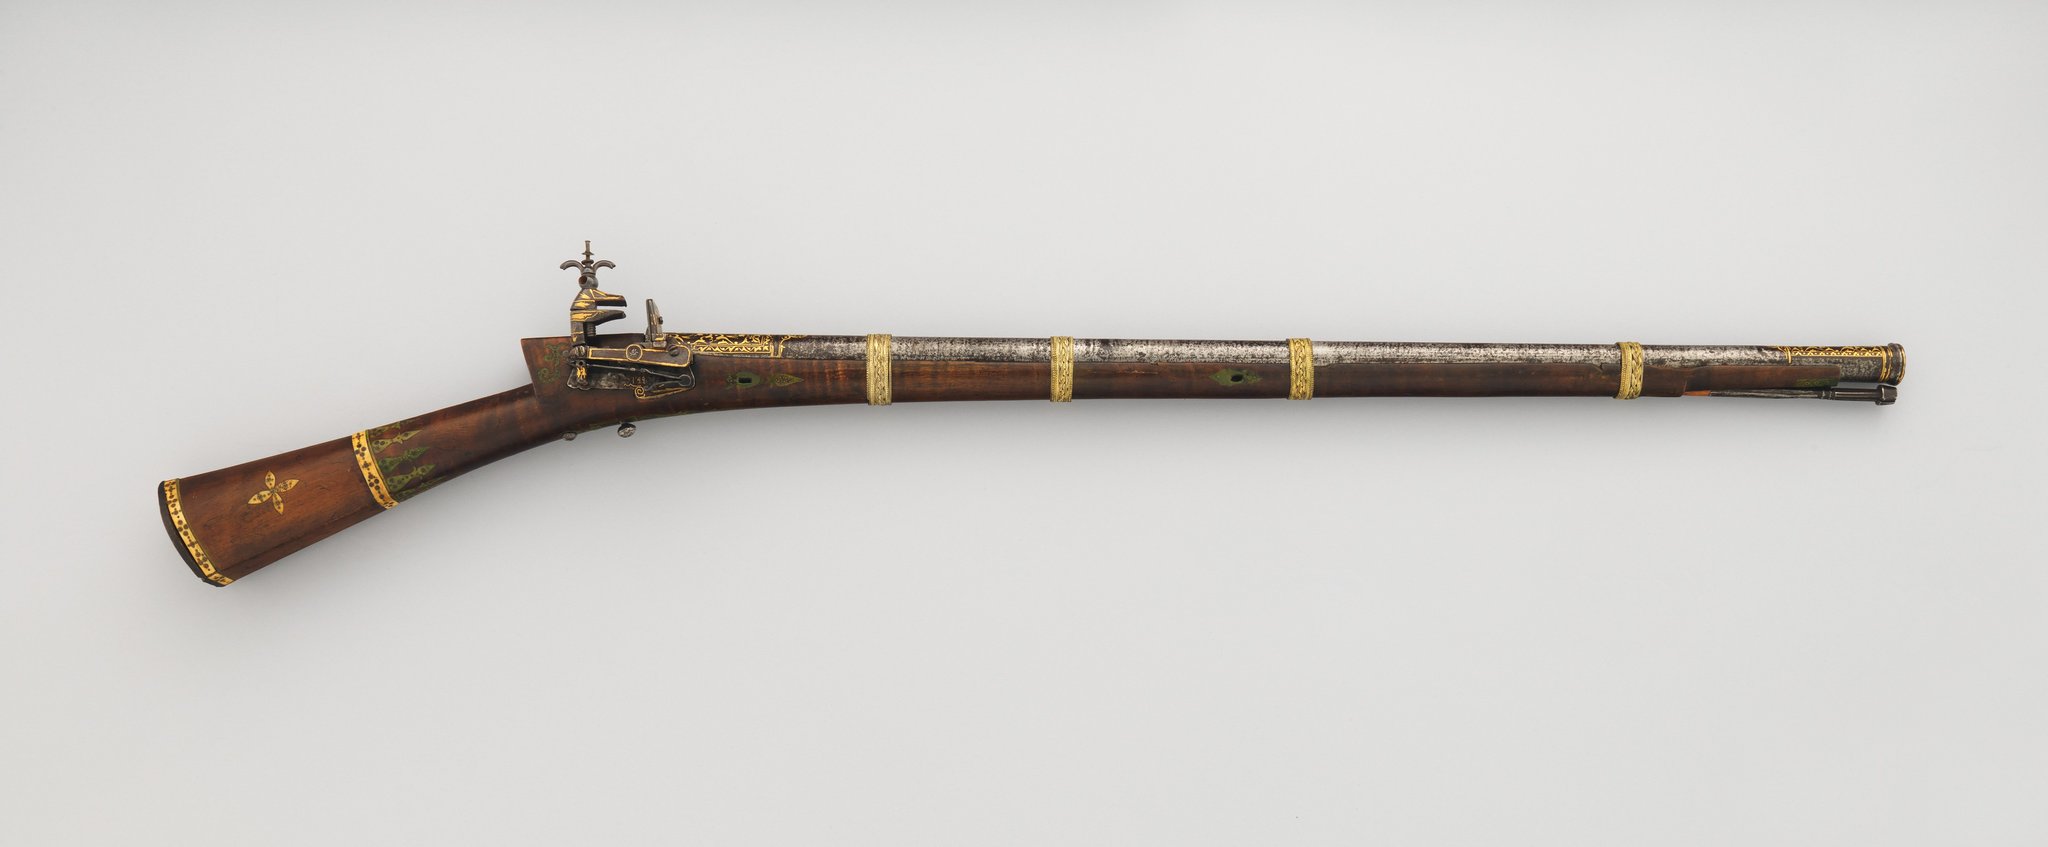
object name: miquelet gun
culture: turkish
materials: bone, copper alloy, gold, steel, wood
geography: turkey